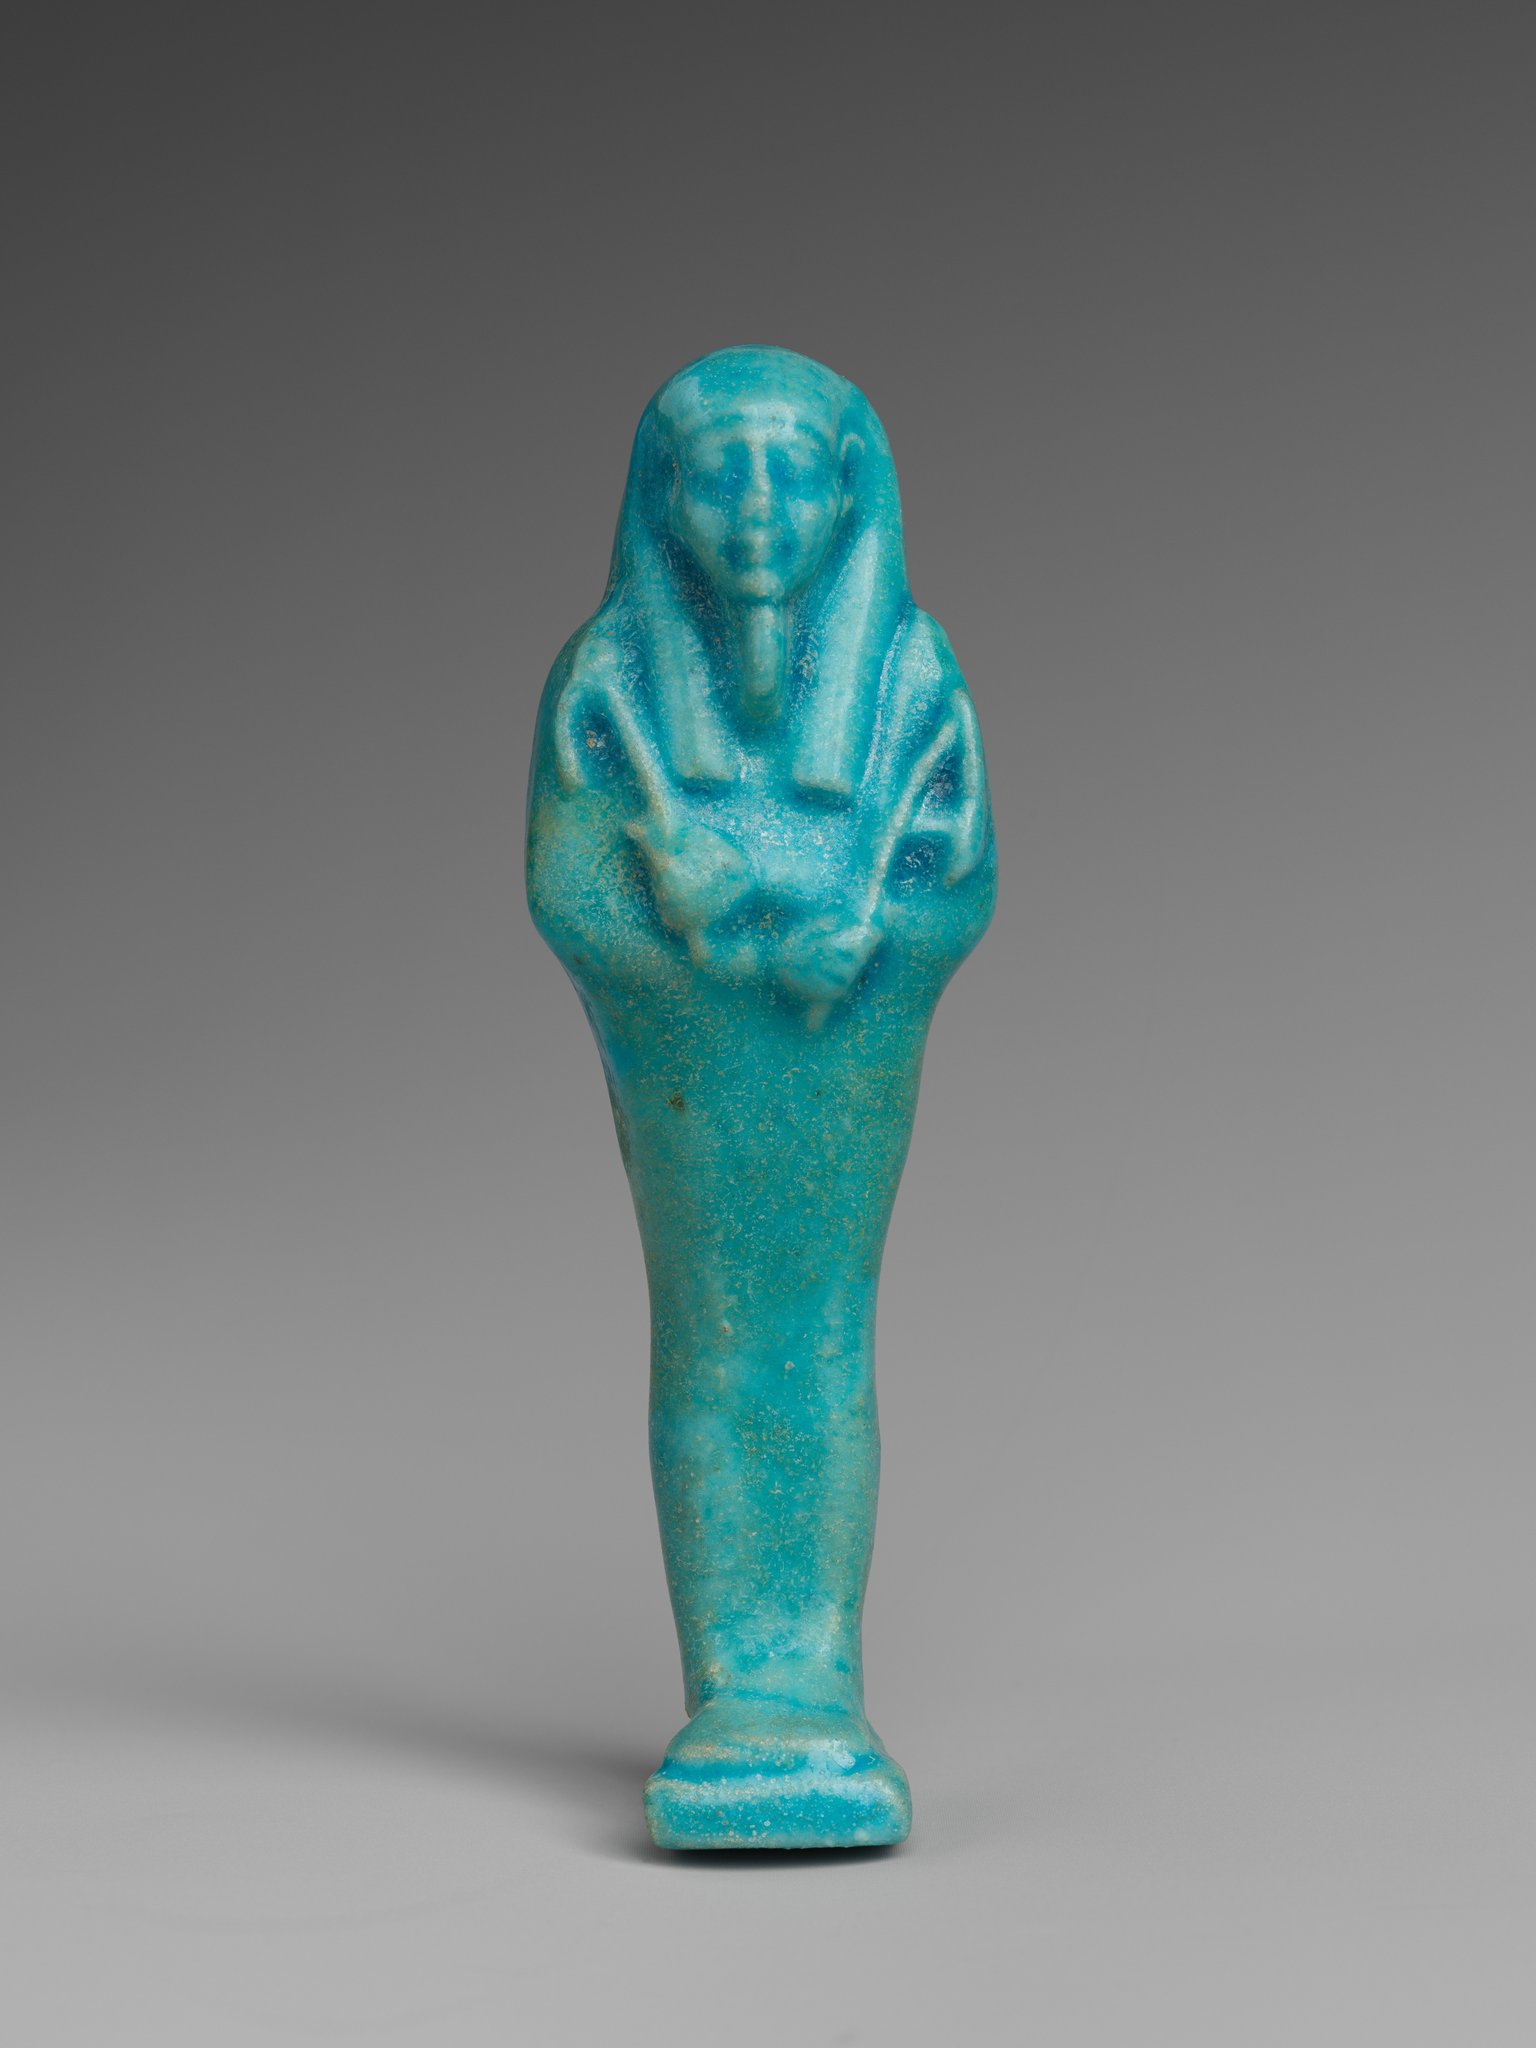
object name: shabti, petosiris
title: Shabti of Petosiris, son of Djedhor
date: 360-300 BCE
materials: faience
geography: egypt